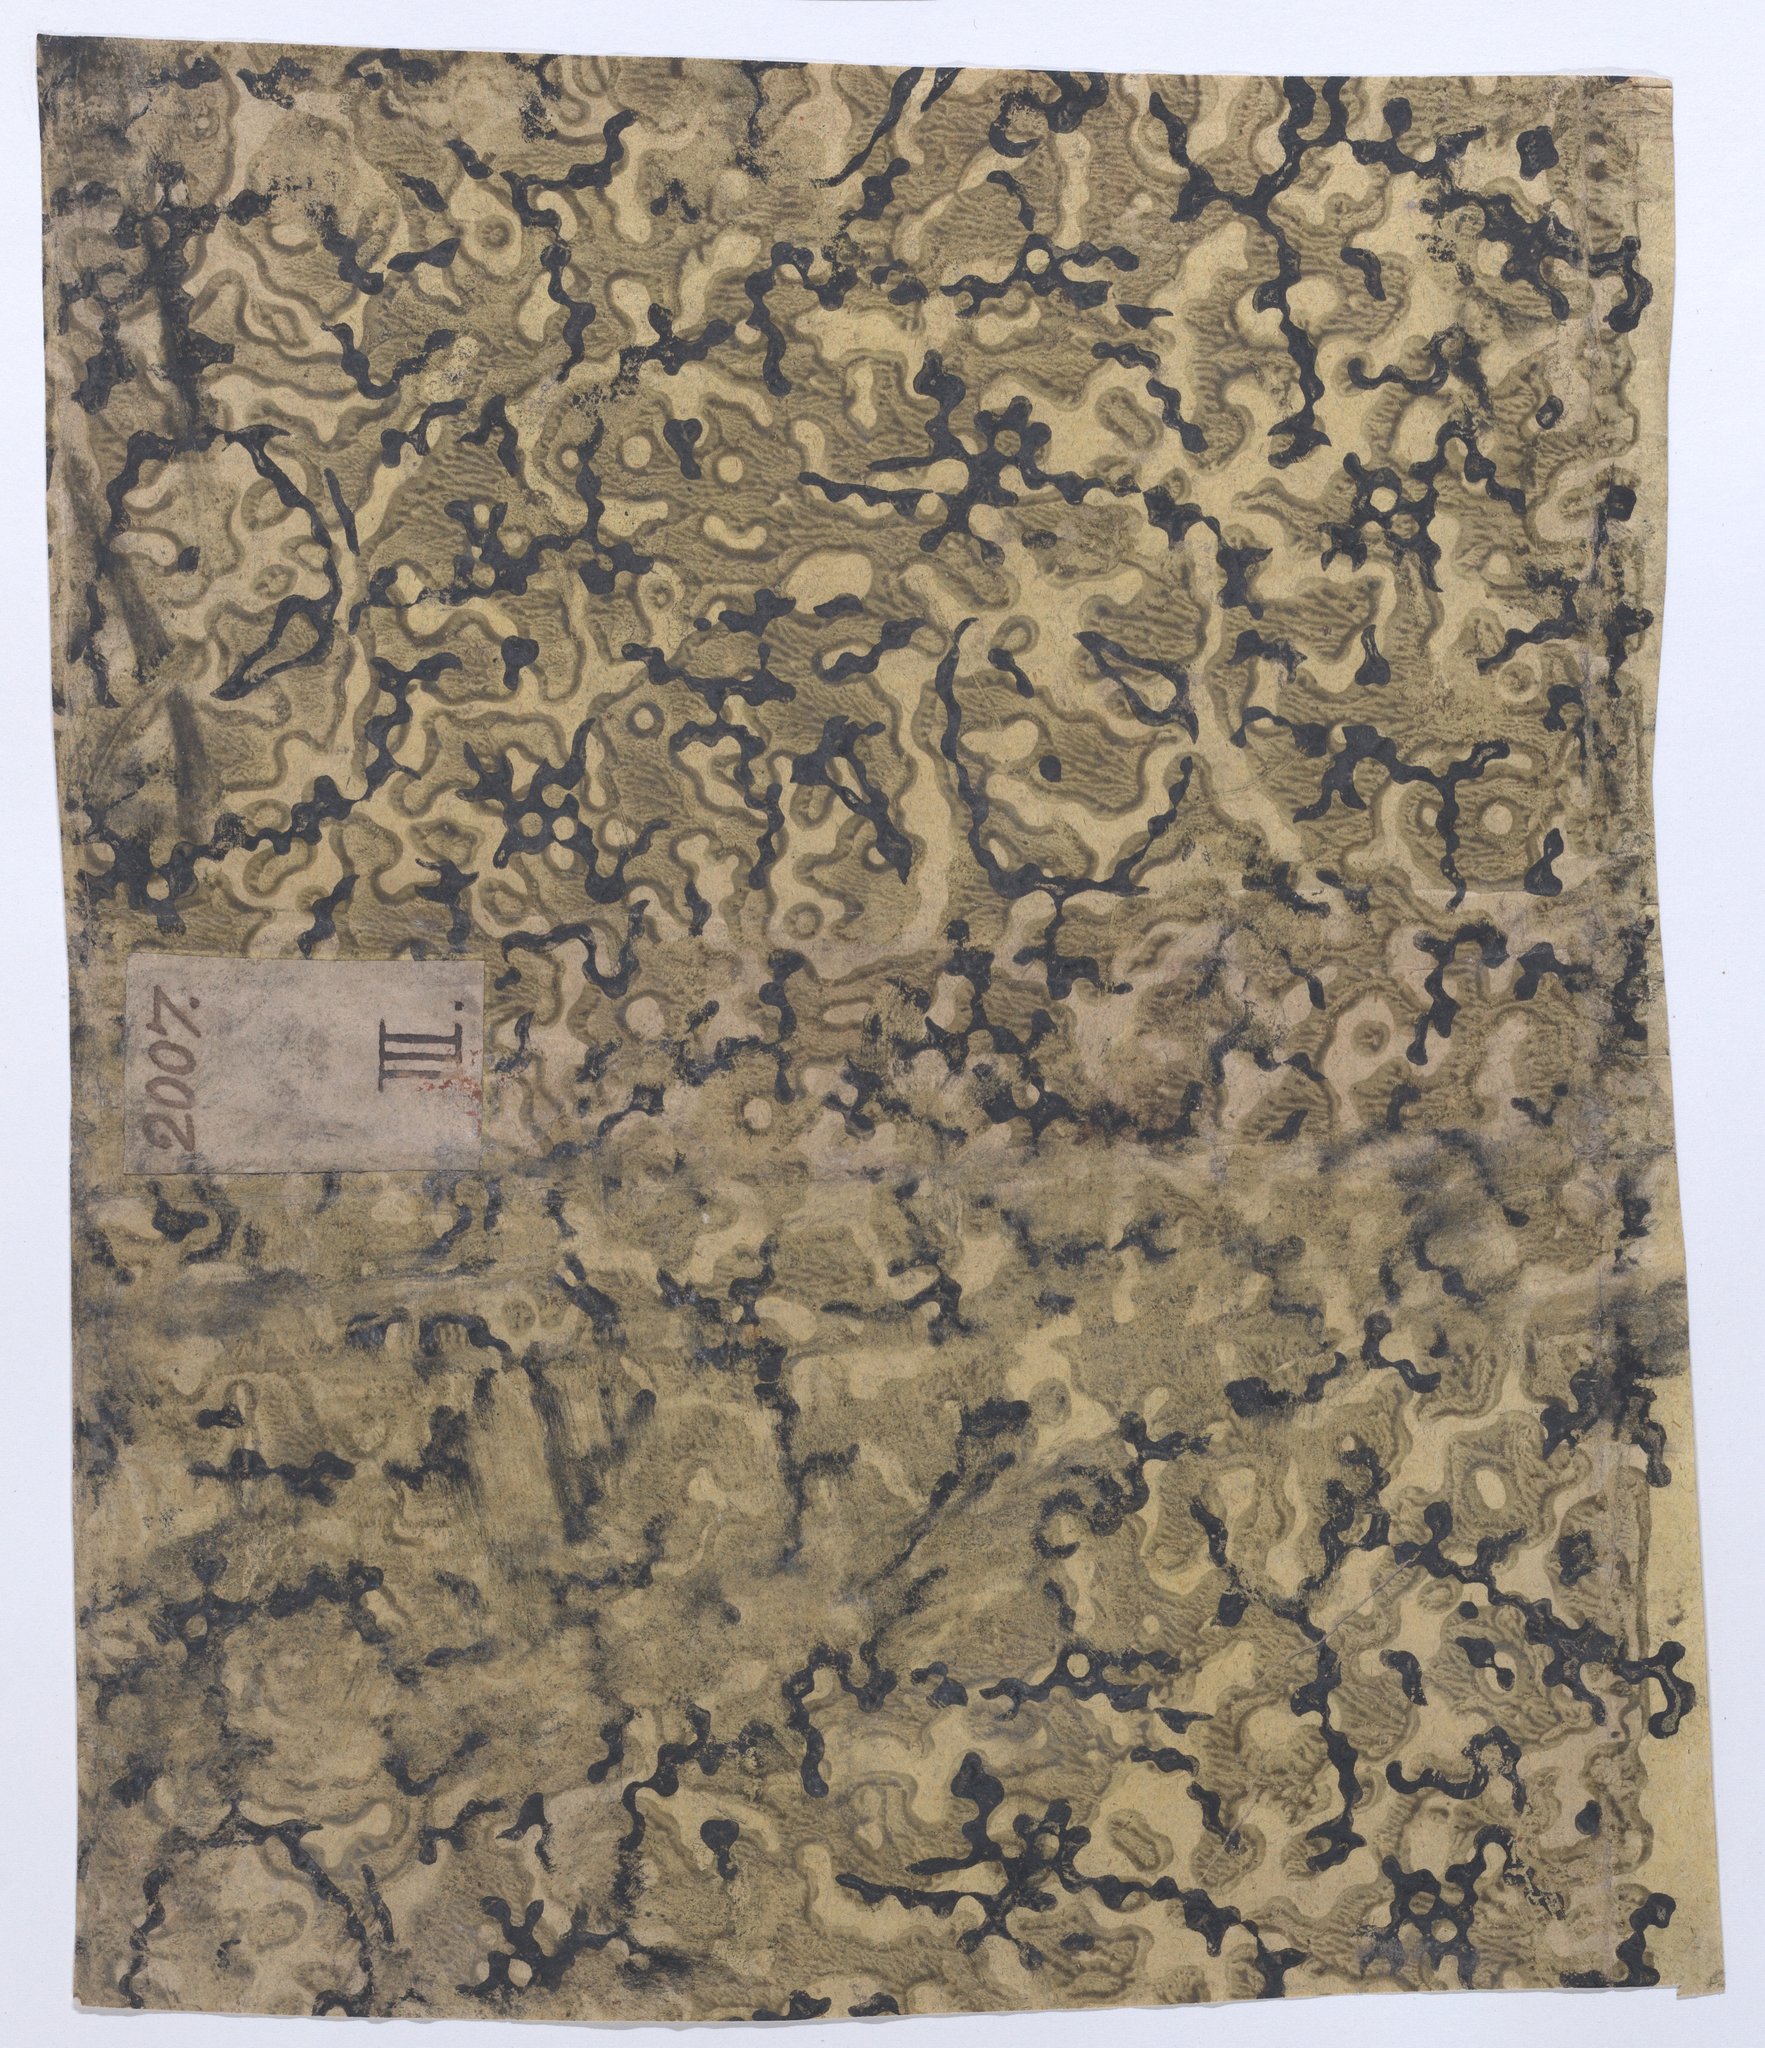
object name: print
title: Book cover with marbled pattern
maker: Anonymous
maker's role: artist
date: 1801-1900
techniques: relief print